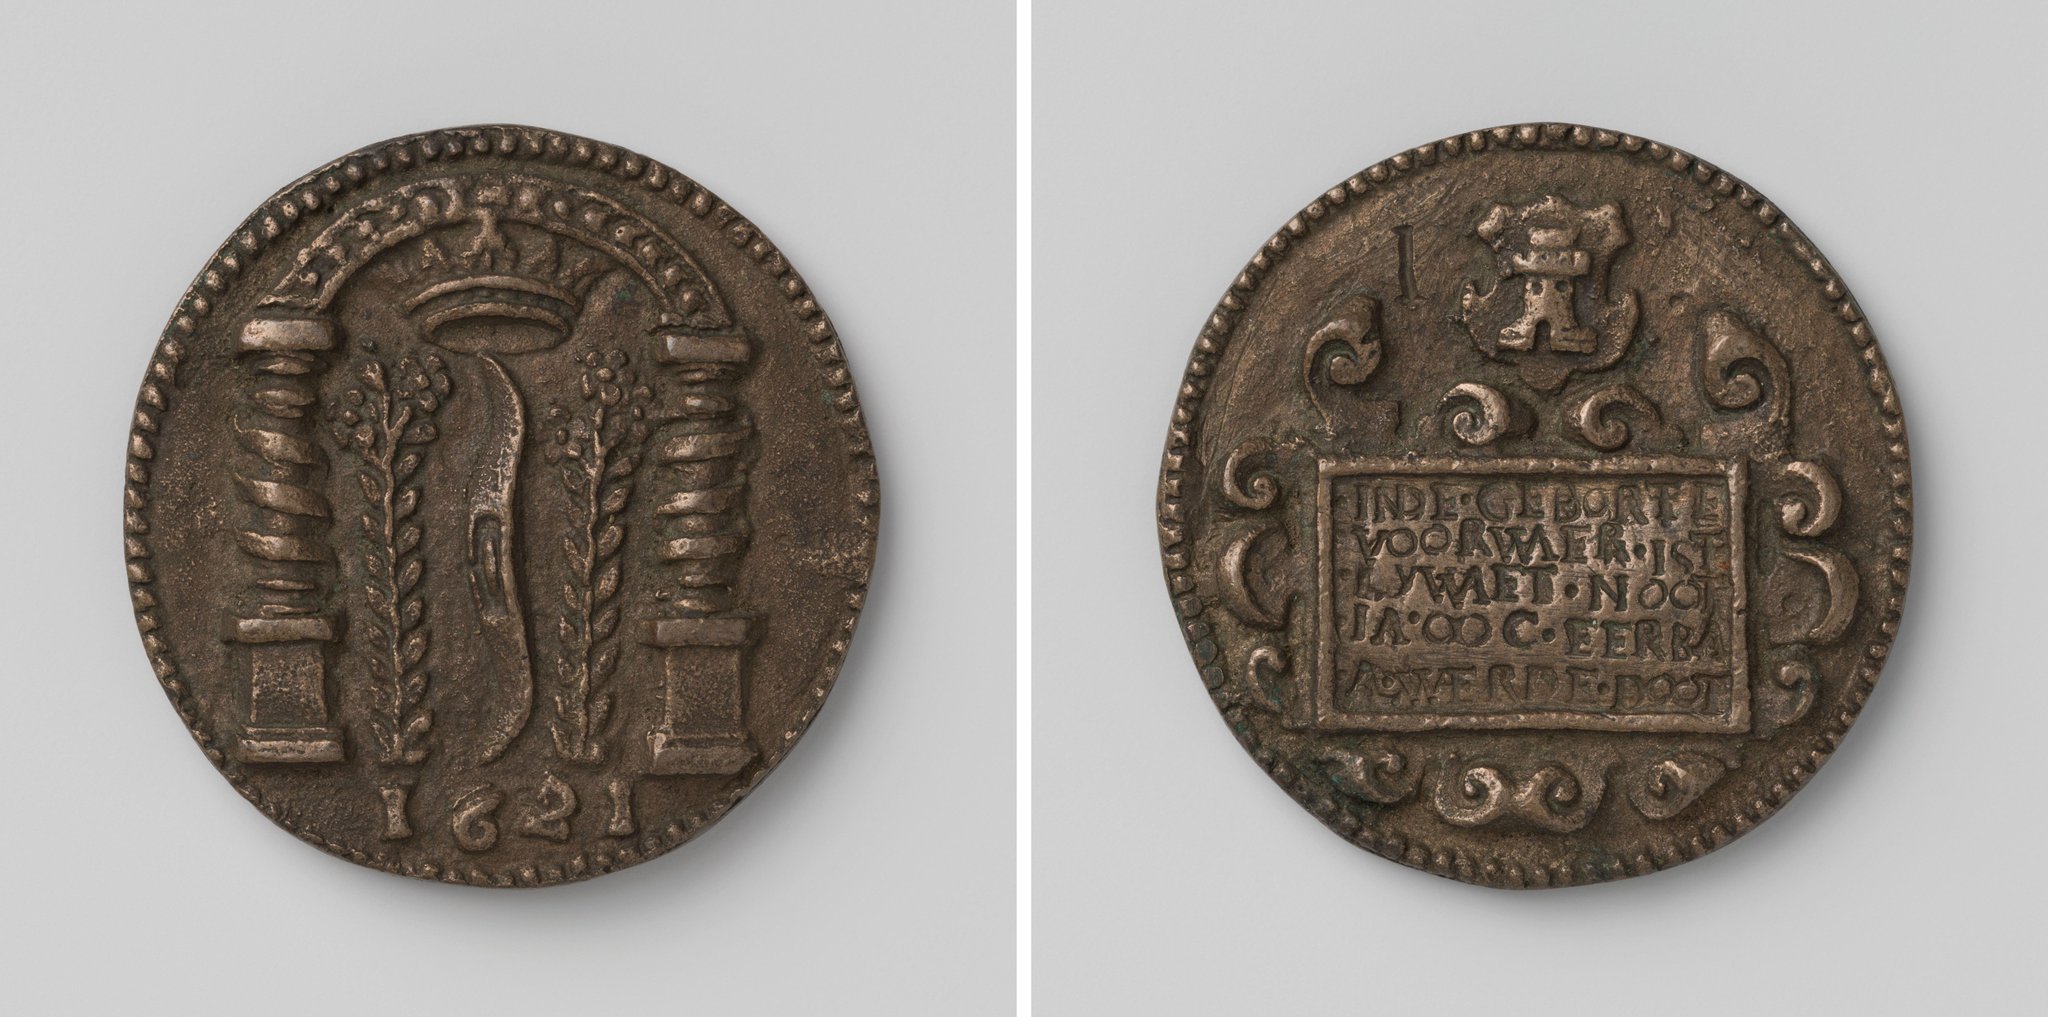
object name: medal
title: Weversgilde van Middelburg, gildepenning met no. 1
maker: Anonymous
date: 1621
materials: copper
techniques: casting, engraving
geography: middelburg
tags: middelburg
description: Koperen penning. Voorzijde: gekroonde, opstaande weversspoel tussen twee bloeiende vlasplanten boven jaartal onder een op twee gekroonde pilaren rustende boog. Keerzijde: wapenschild boven tableau met opschrift in cartouche; naast wapenschild: cijfer 1